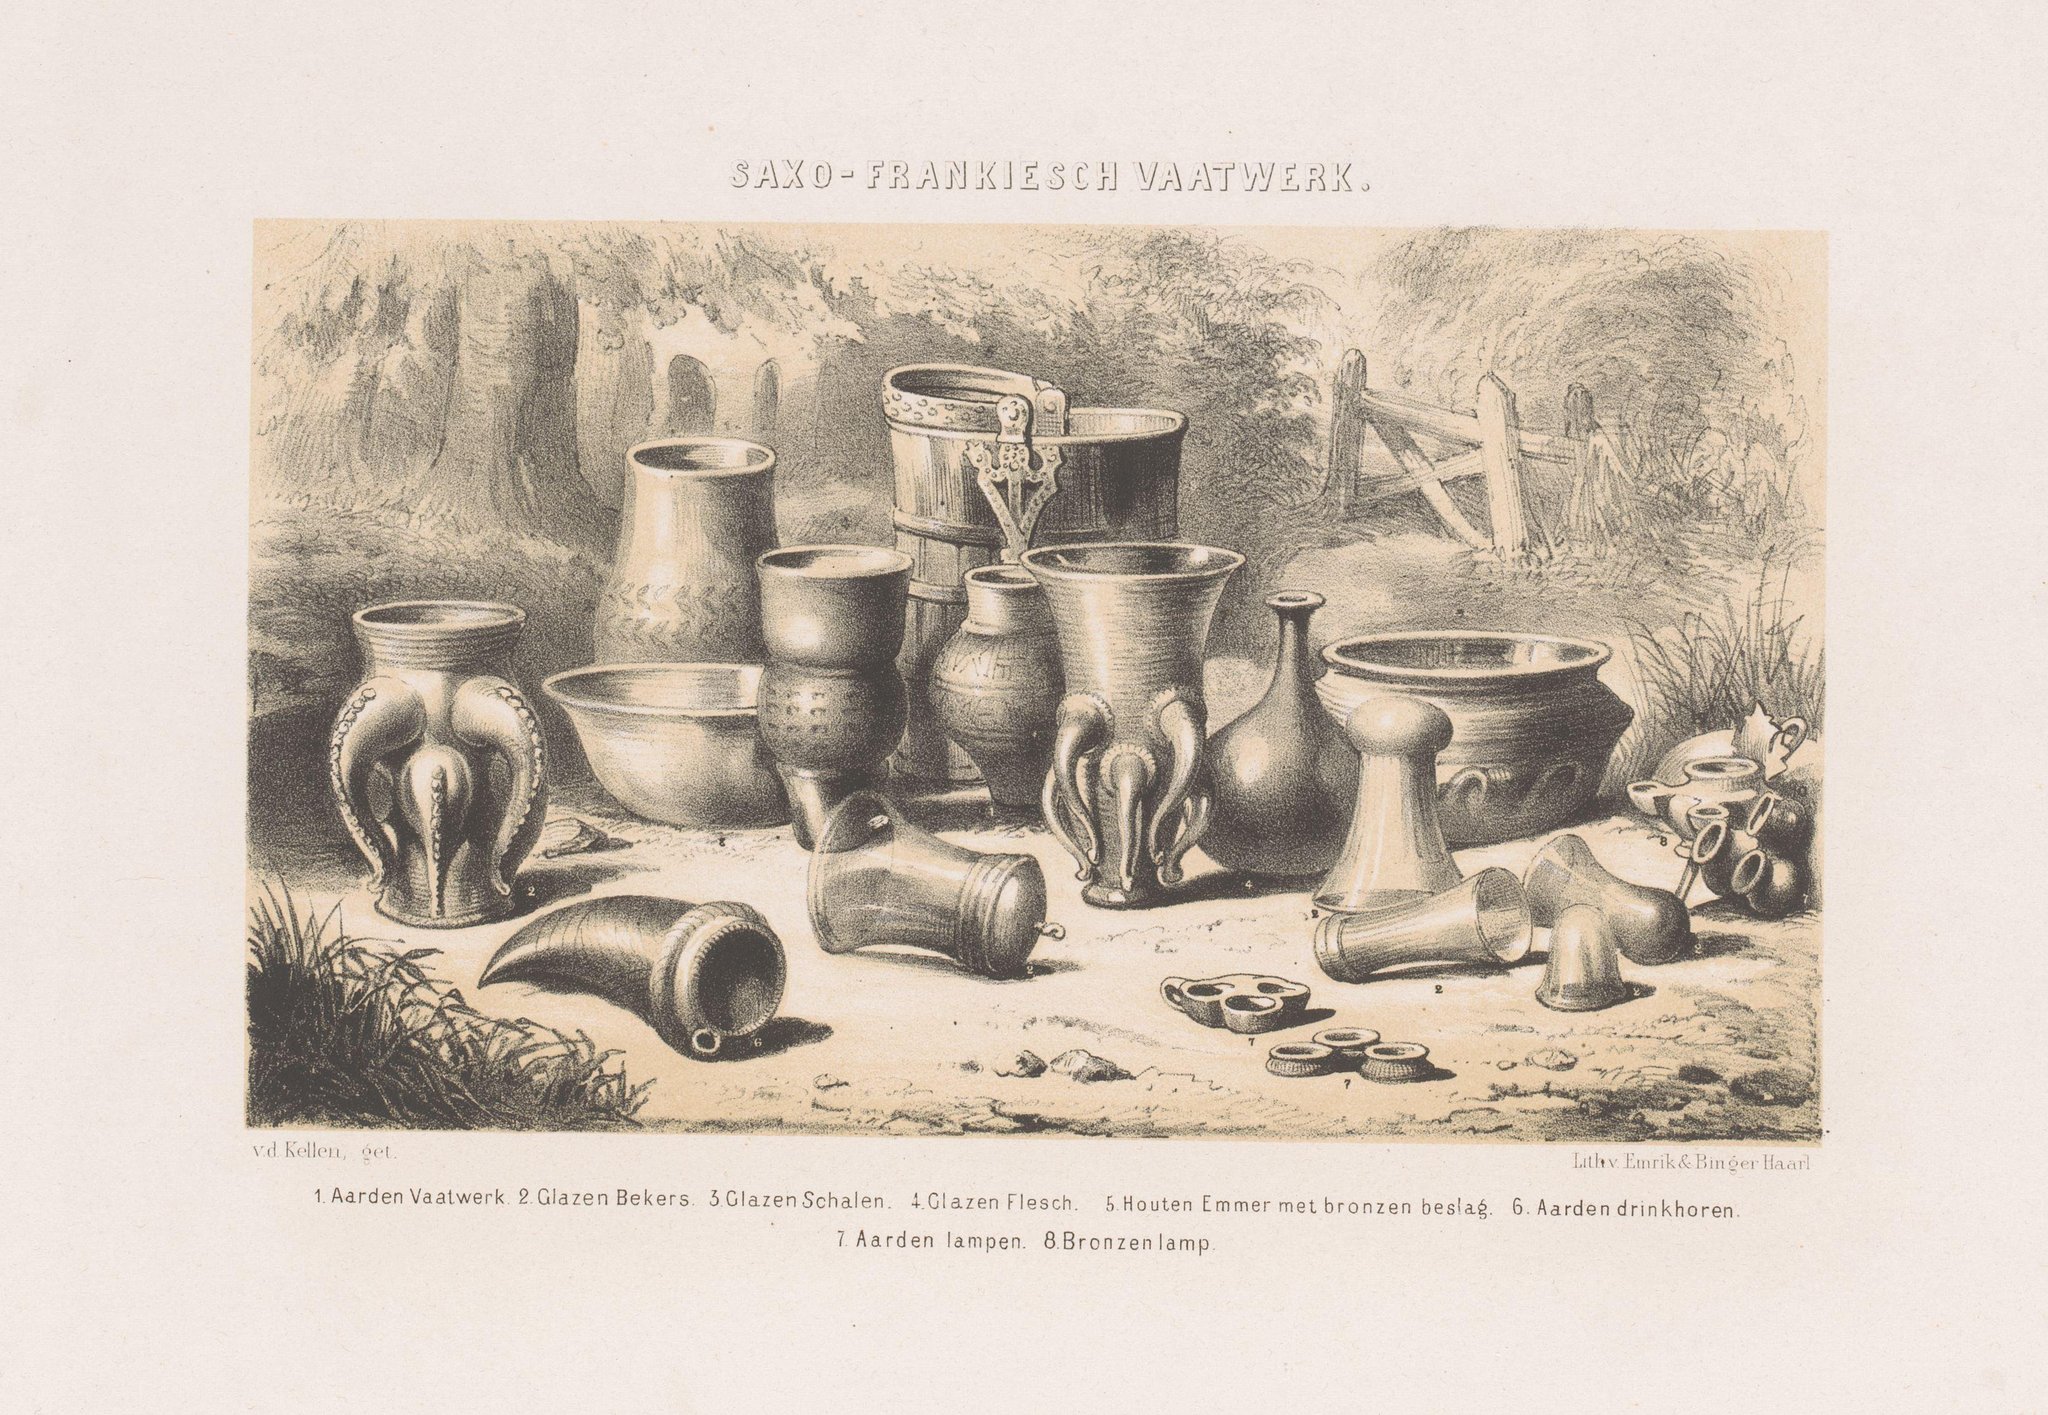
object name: historical object representation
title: Saxo-Frankisch vaatwerk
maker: david van der kellen (1827-1895)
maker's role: draughtsman, print maker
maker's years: 1827-1895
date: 1857-1864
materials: paper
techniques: tone lithography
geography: haarlem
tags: netherlands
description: Illustratie voor: W.J. Hofdijk, Ons voorgeslacht in zijn dagelyksch leven geschilderd, Kruseman, Haarlem 1859-1864.